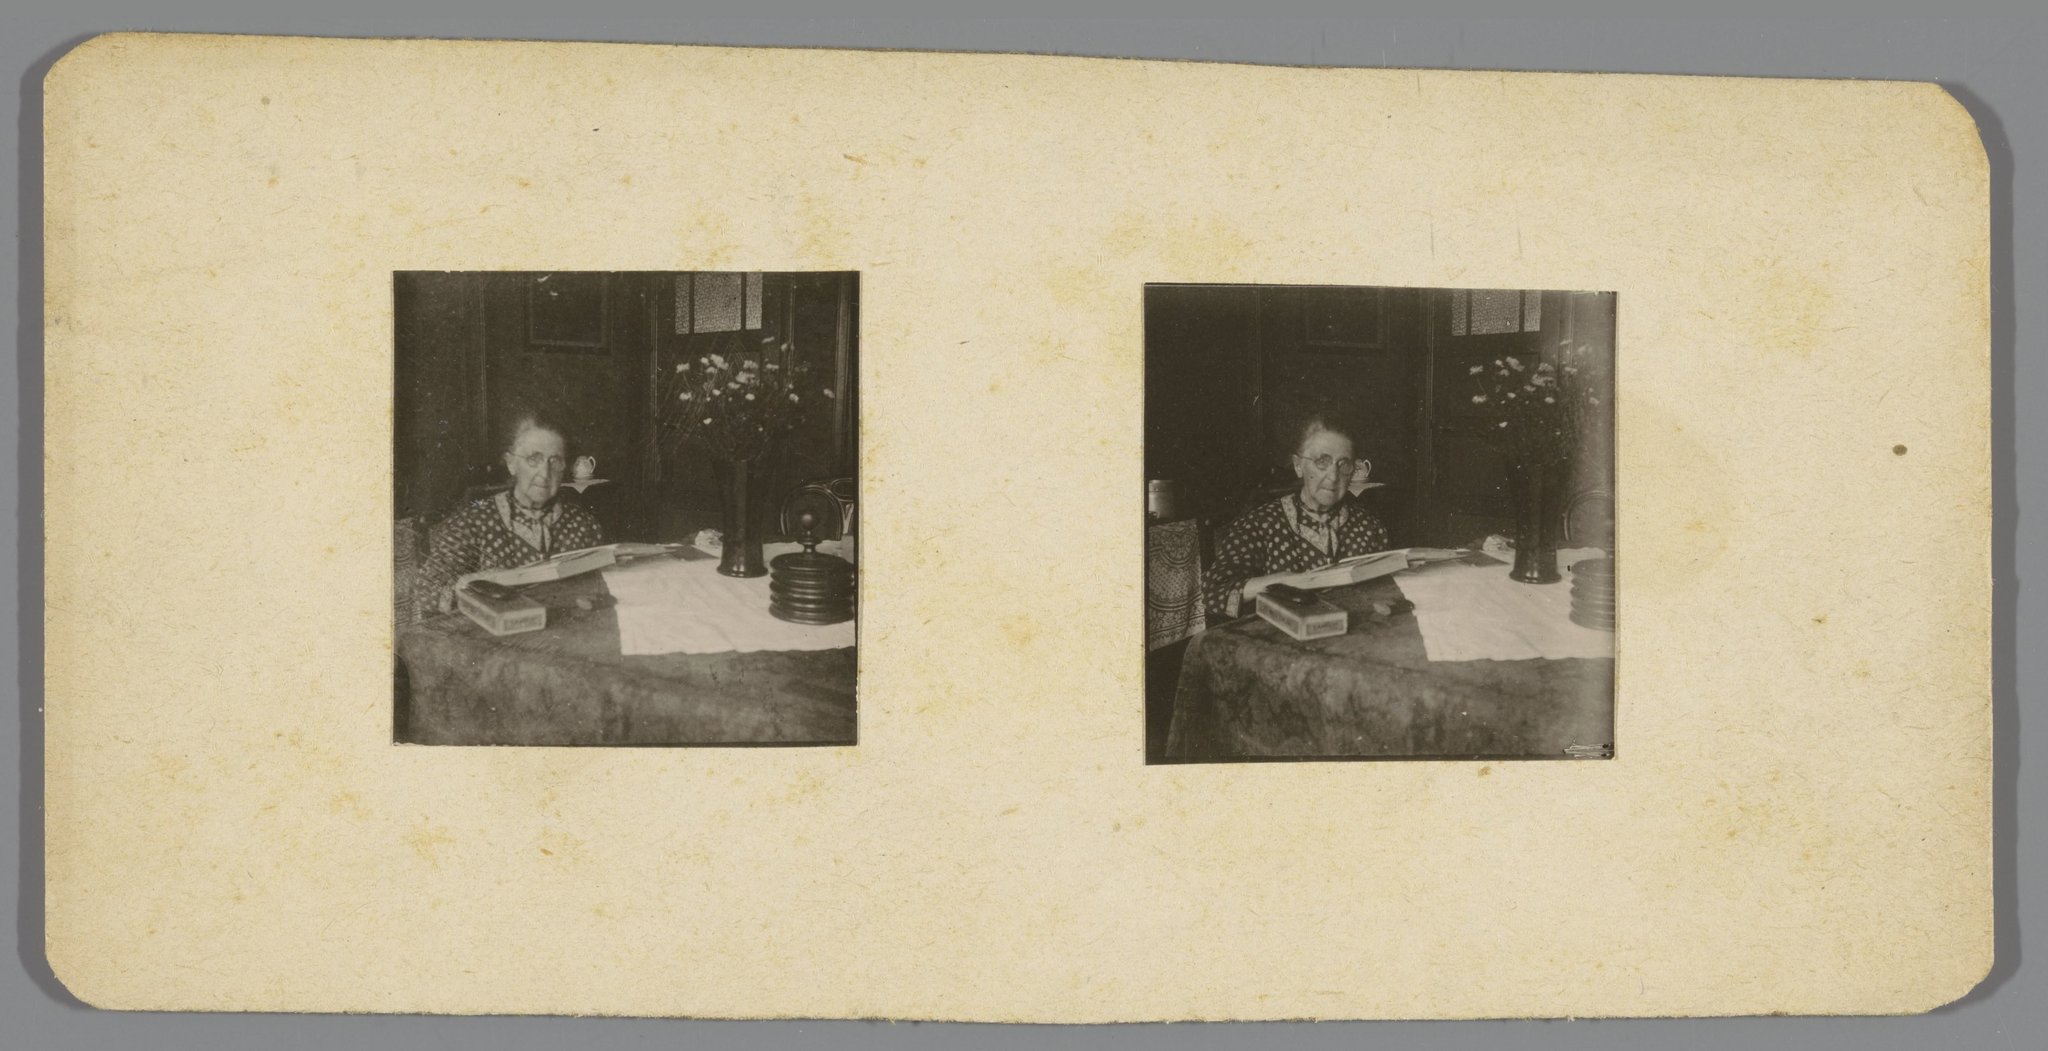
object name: stereograph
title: Portret van een onbekende oude vrouw met boek aan tafel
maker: Anonymous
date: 1900-1940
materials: paper, cardboard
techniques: gelatin silver print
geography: netherlands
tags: reading, historical persons not known by name - bb - woman, old woman